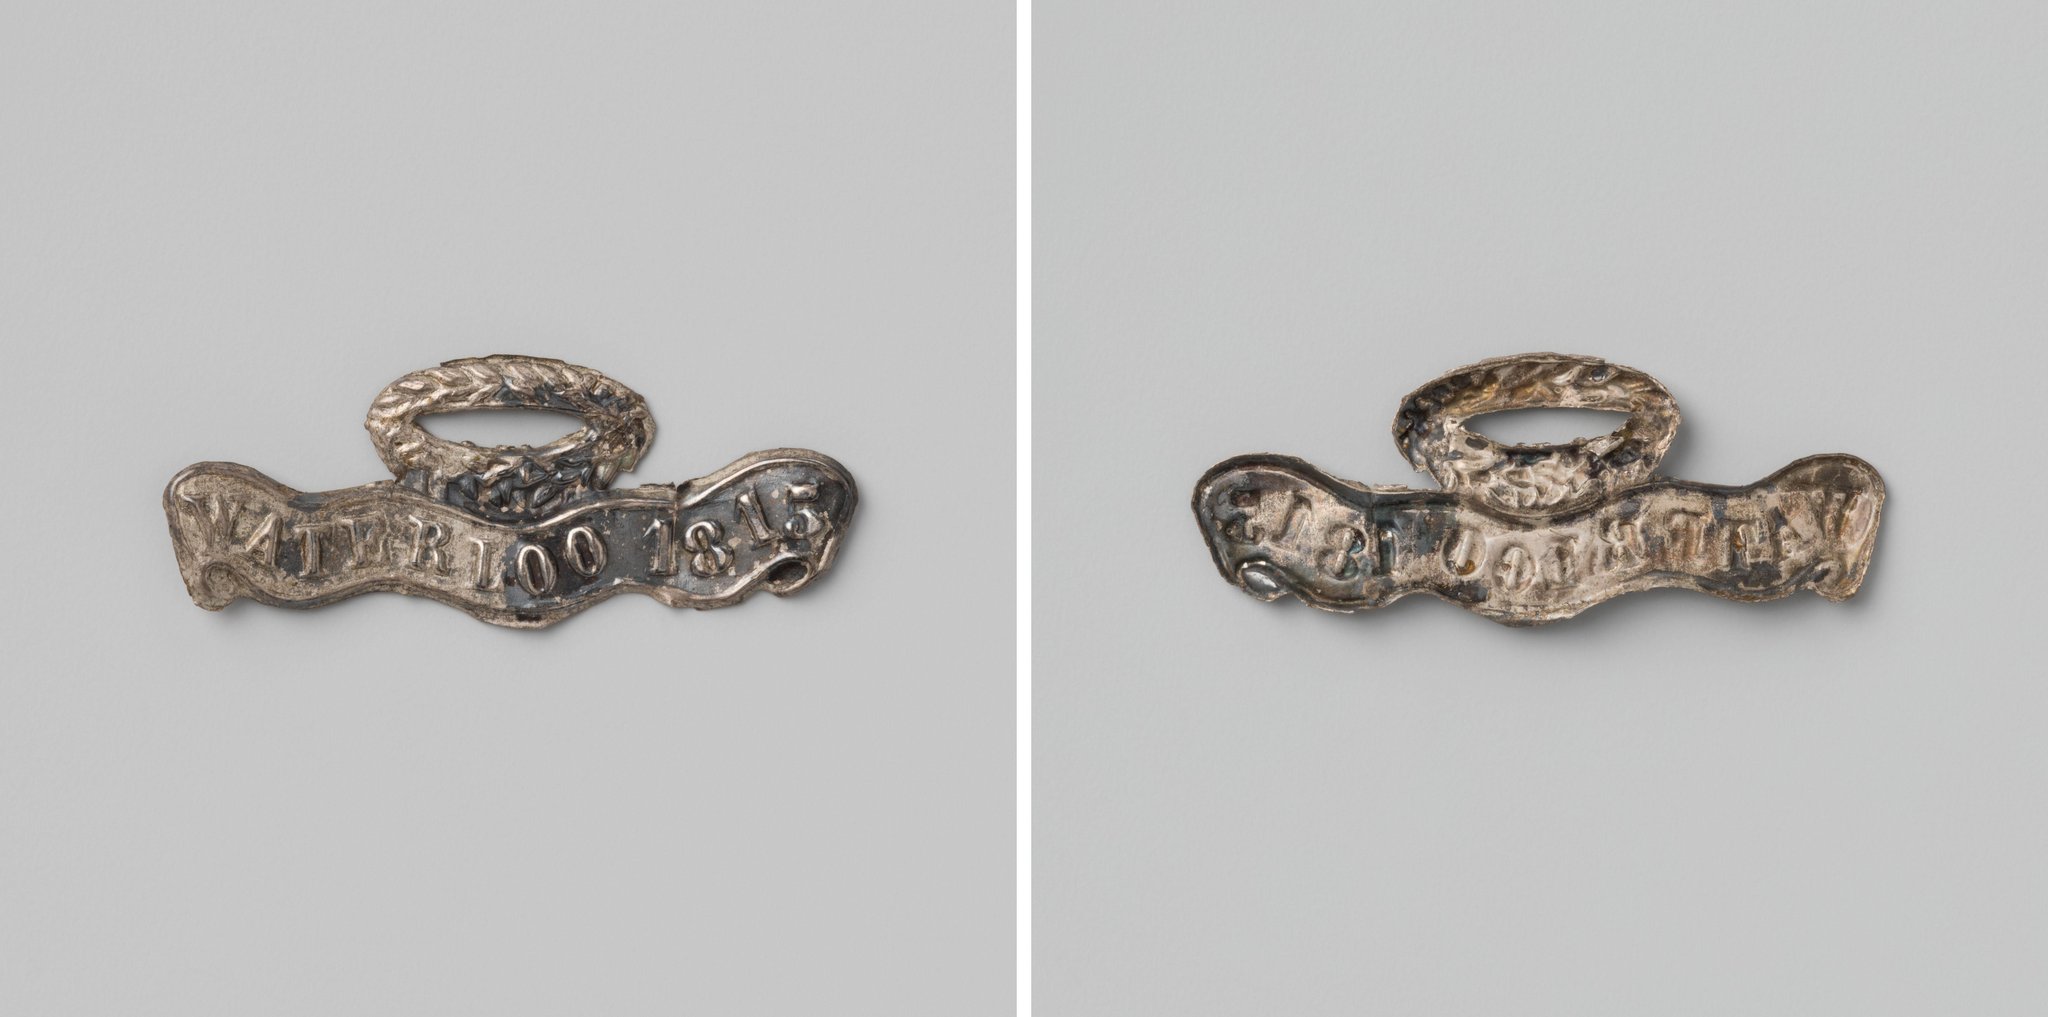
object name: insignia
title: Vijftigjarige viering van slag bij Waterloo, draagteken ter ere van Willem II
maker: Anonymous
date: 1865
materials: silver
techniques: striking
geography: netherlands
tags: the hague, william ii of the netherlands, waterloo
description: Eenzijdig zilveren draagteken, bestaande uit een lauwerkrans op wimpel met opschrift